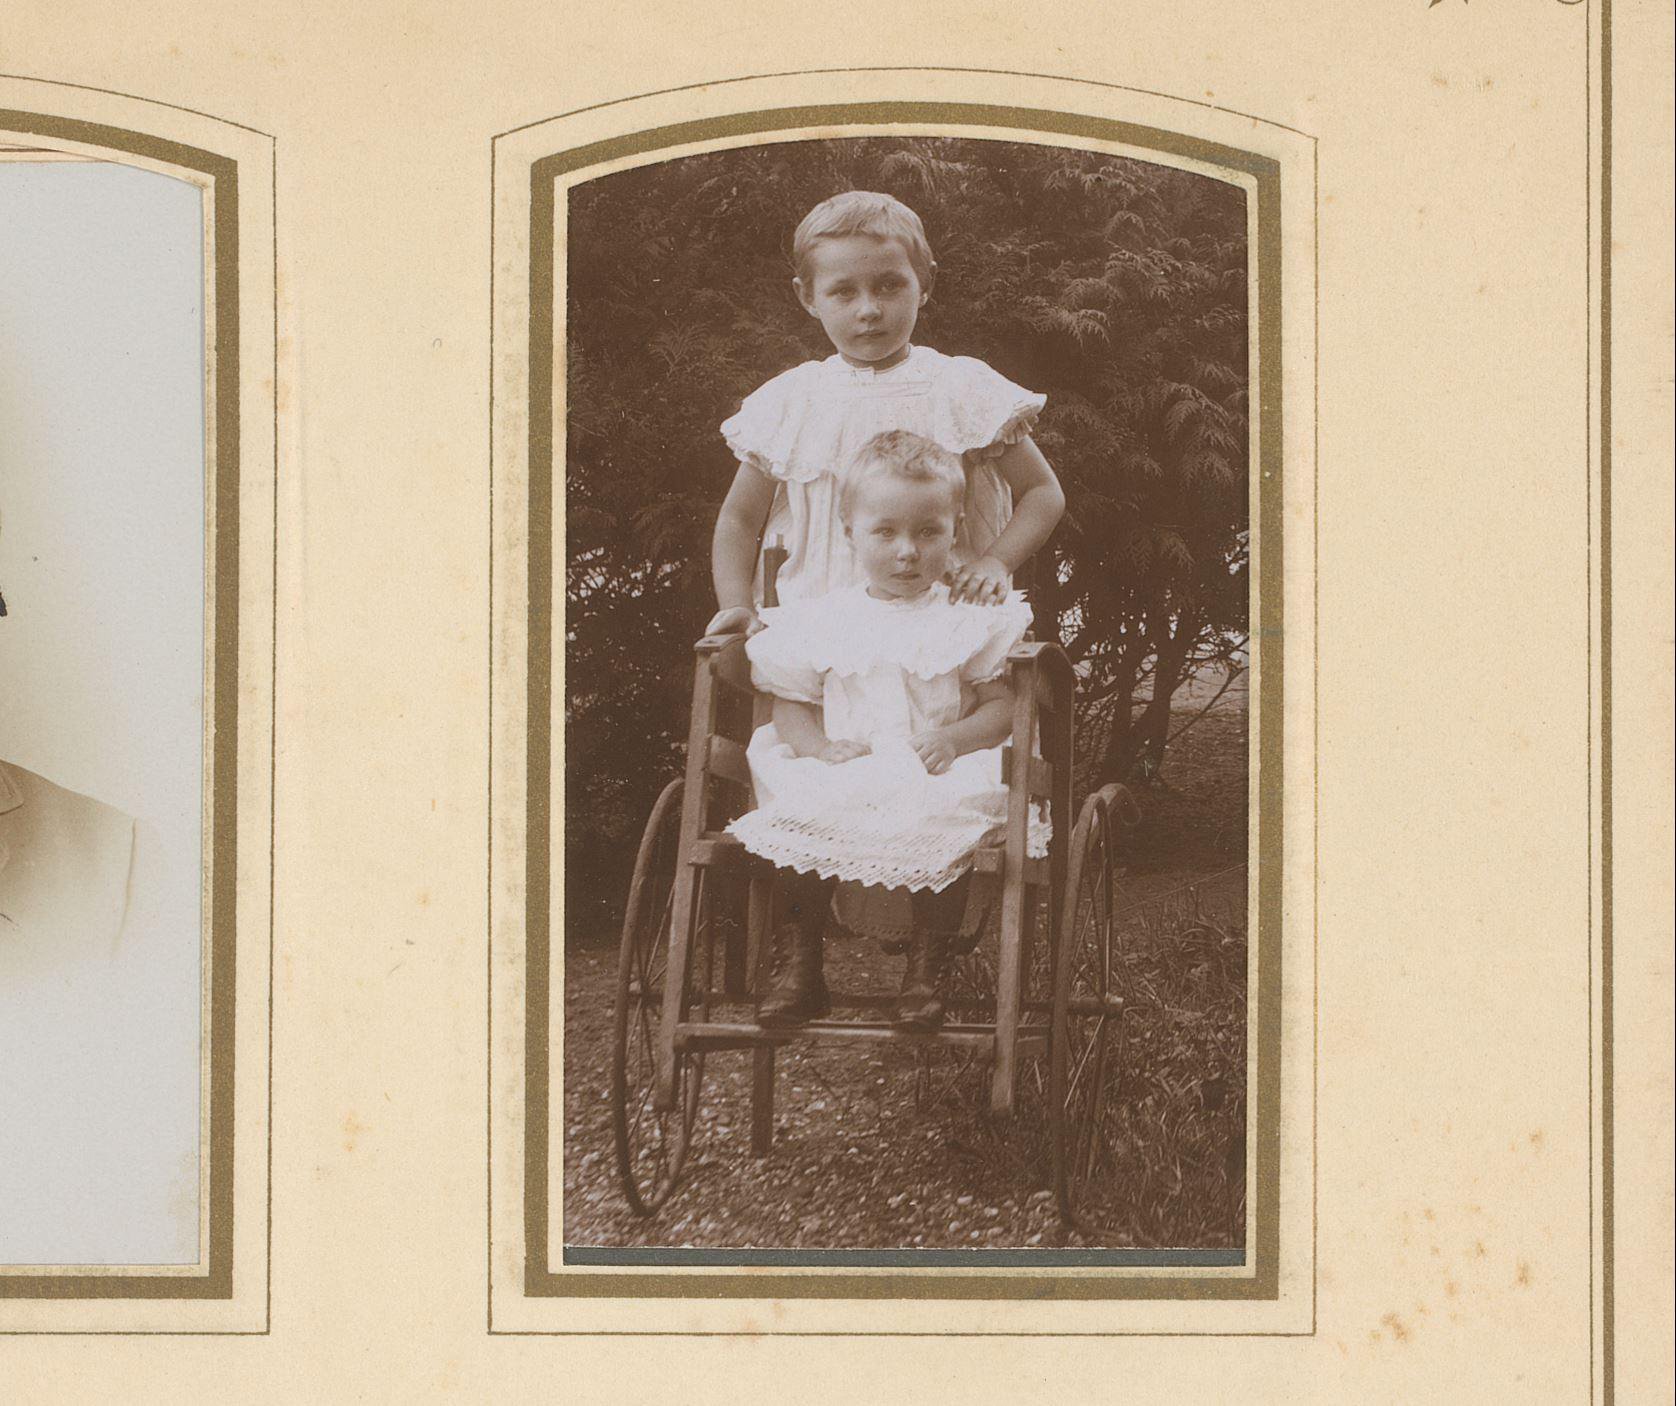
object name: photograph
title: Portret van twee meisjes in witte jurken in een tuin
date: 1903-1945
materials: cardboard, photographic support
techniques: collodion silver print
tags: historical persons - bb - woman, garden, child (+ two persons)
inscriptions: inscription: ‘E. Meyer/ Groningen/ Assen’